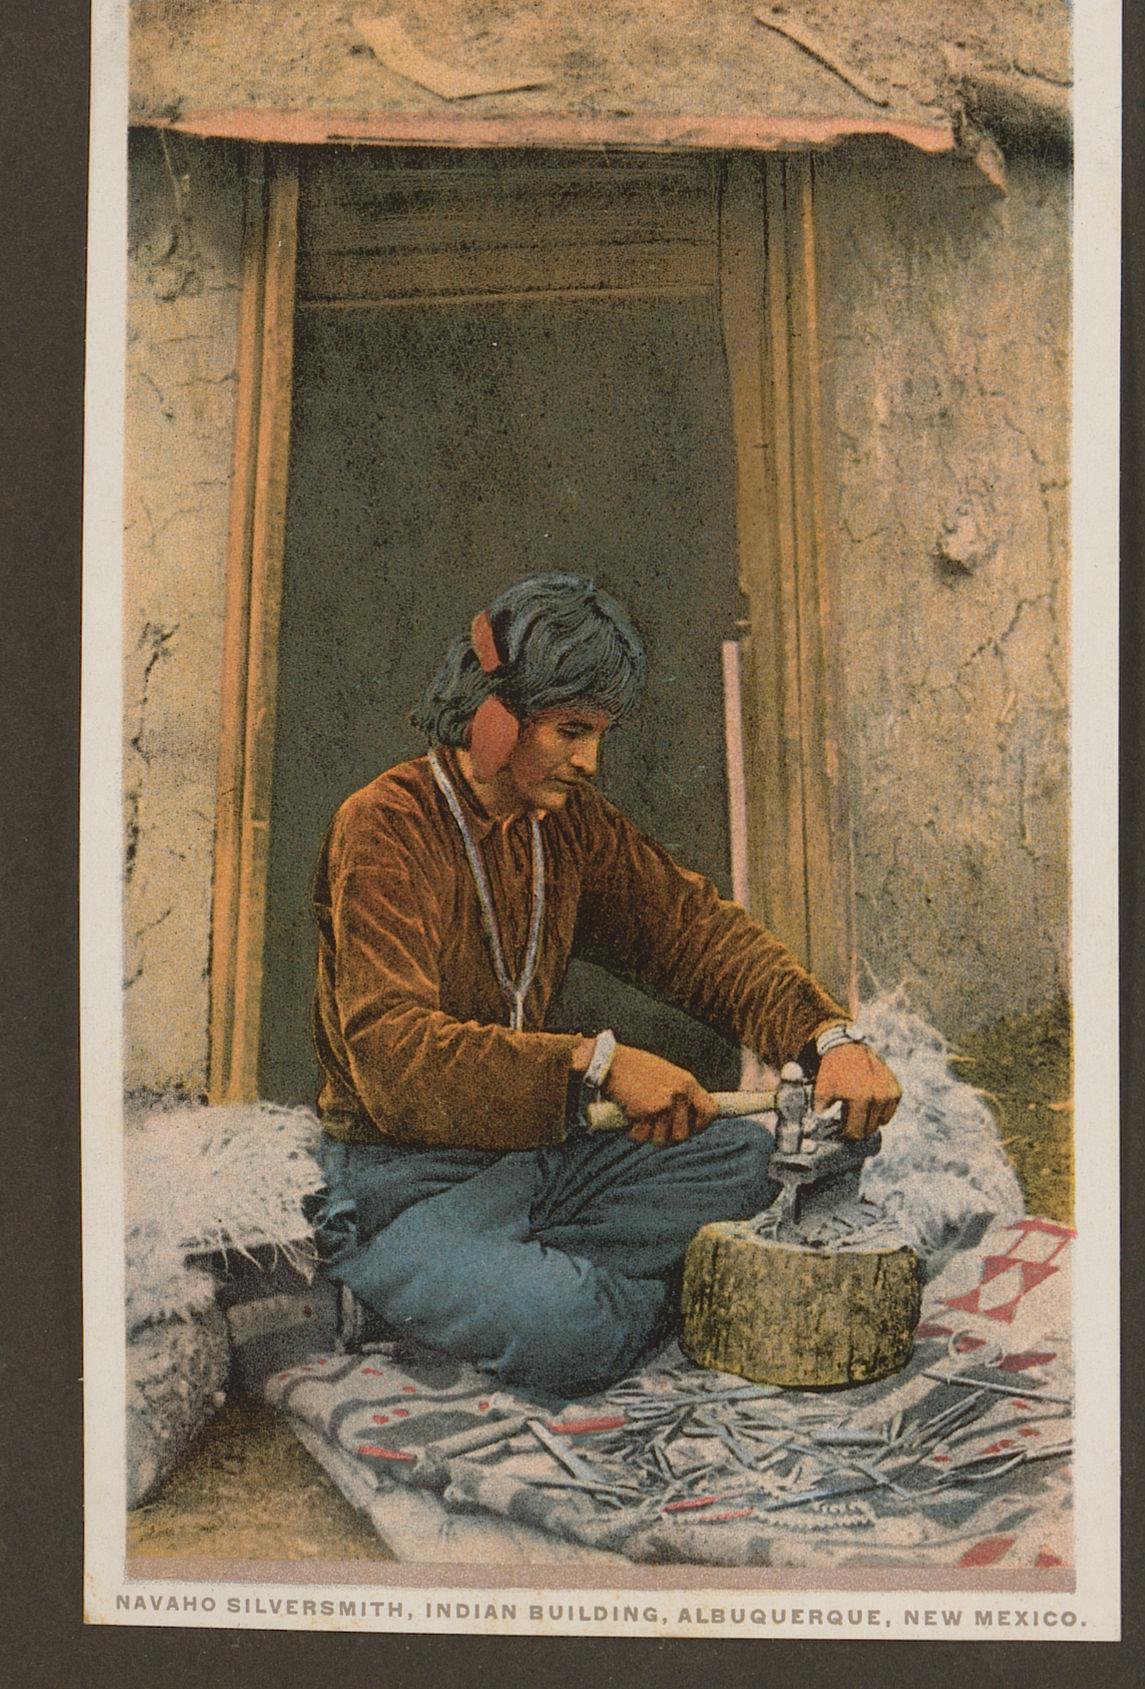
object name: album leaf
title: Navaho silversmith, Indian building, Albuquerque, New Mexico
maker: Anonymous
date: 1928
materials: paper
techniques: chromolithography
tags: adult man, indigenous peoples of north america, jeweller, goldsmith, silversmith